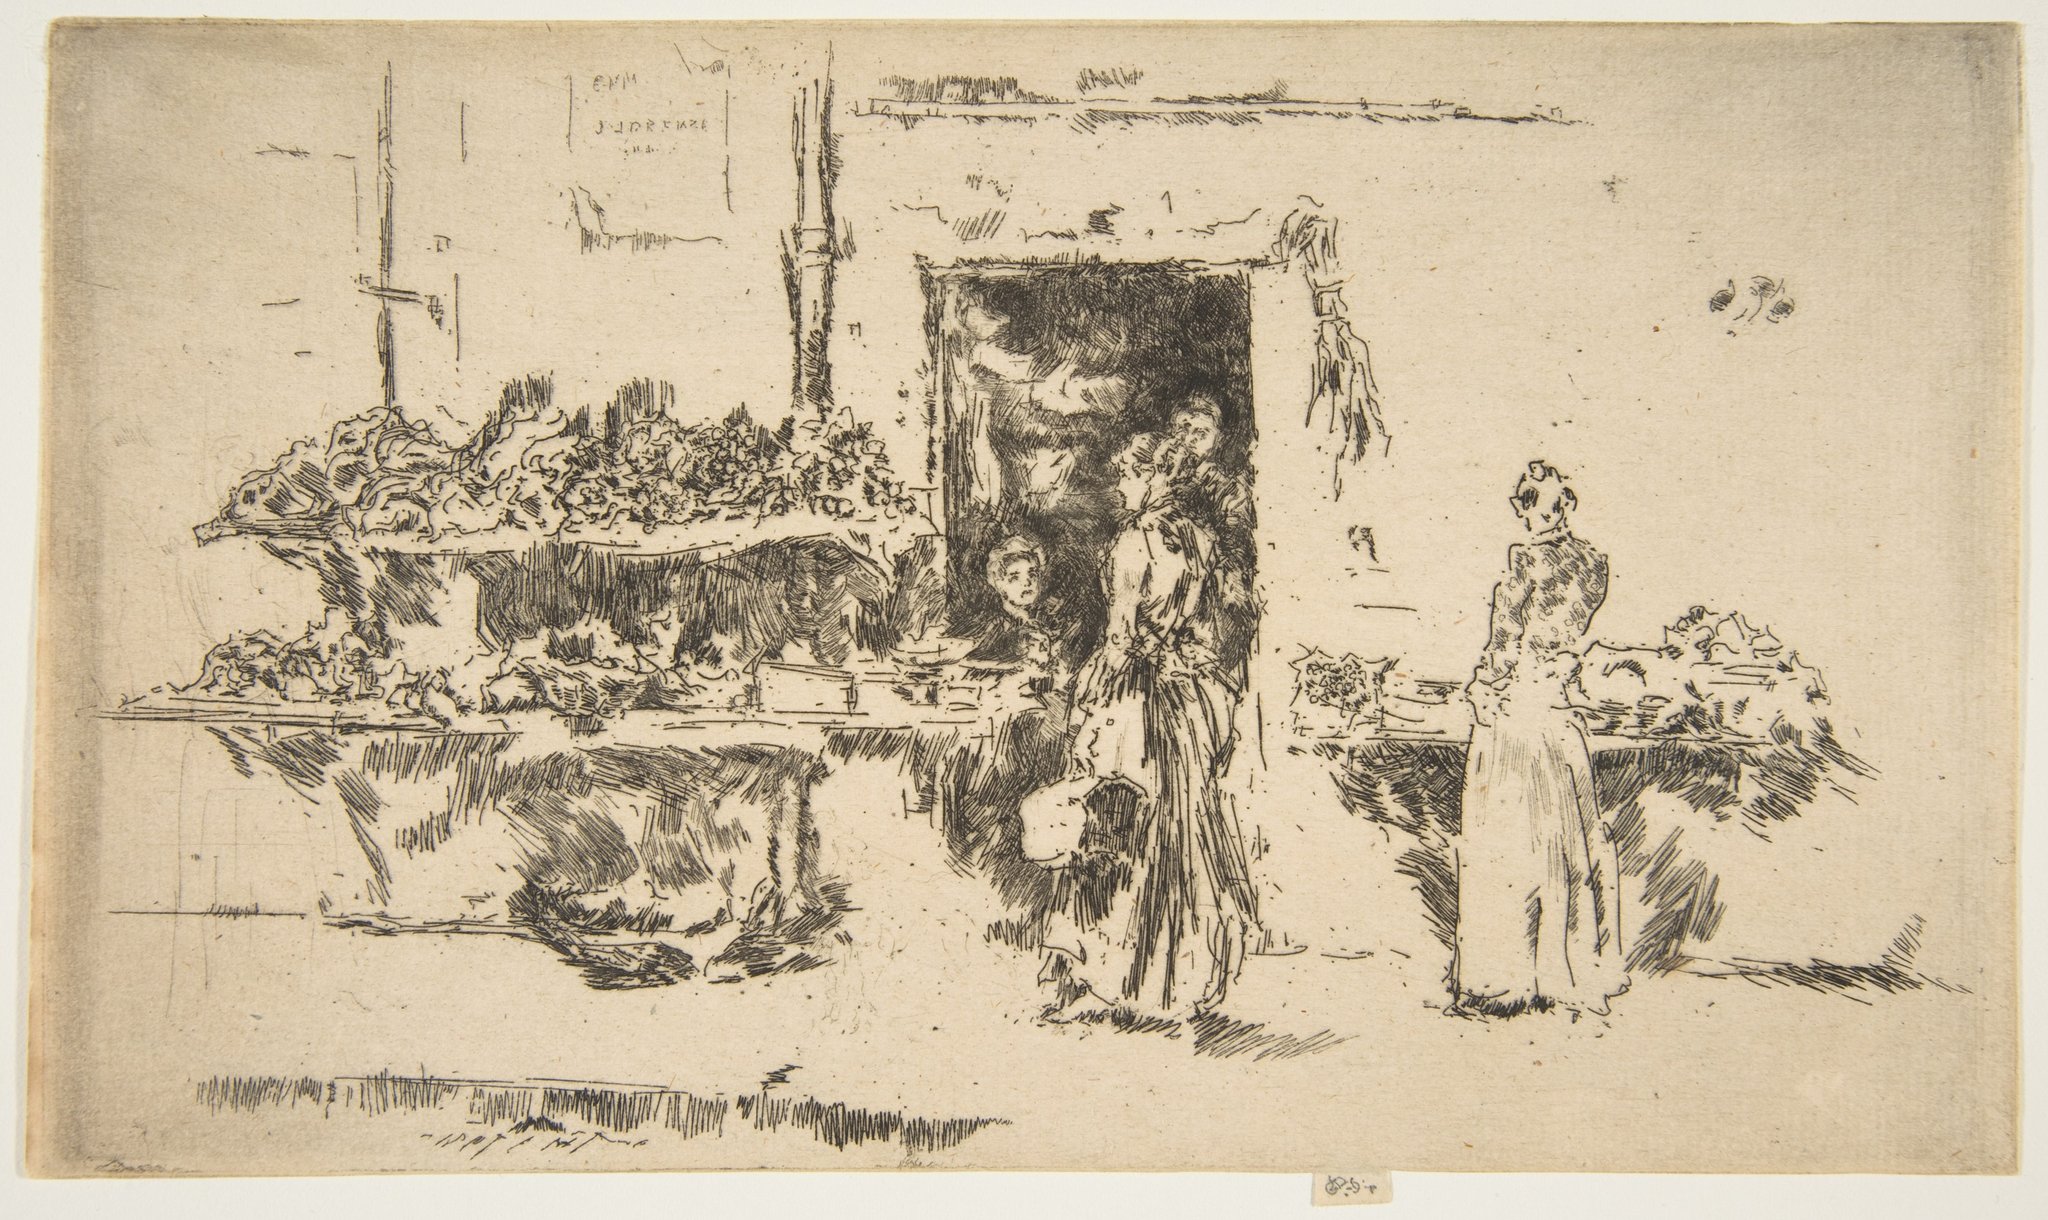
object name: print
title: Fruit-Shop, Paris (Greengrocer's Shop, Paris)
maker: james mcneill whistler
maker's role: artist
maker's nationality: american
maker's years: 1834-1903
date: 1892-1893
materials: ink, paper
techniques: drypoint, etching, printing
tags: fruit,women